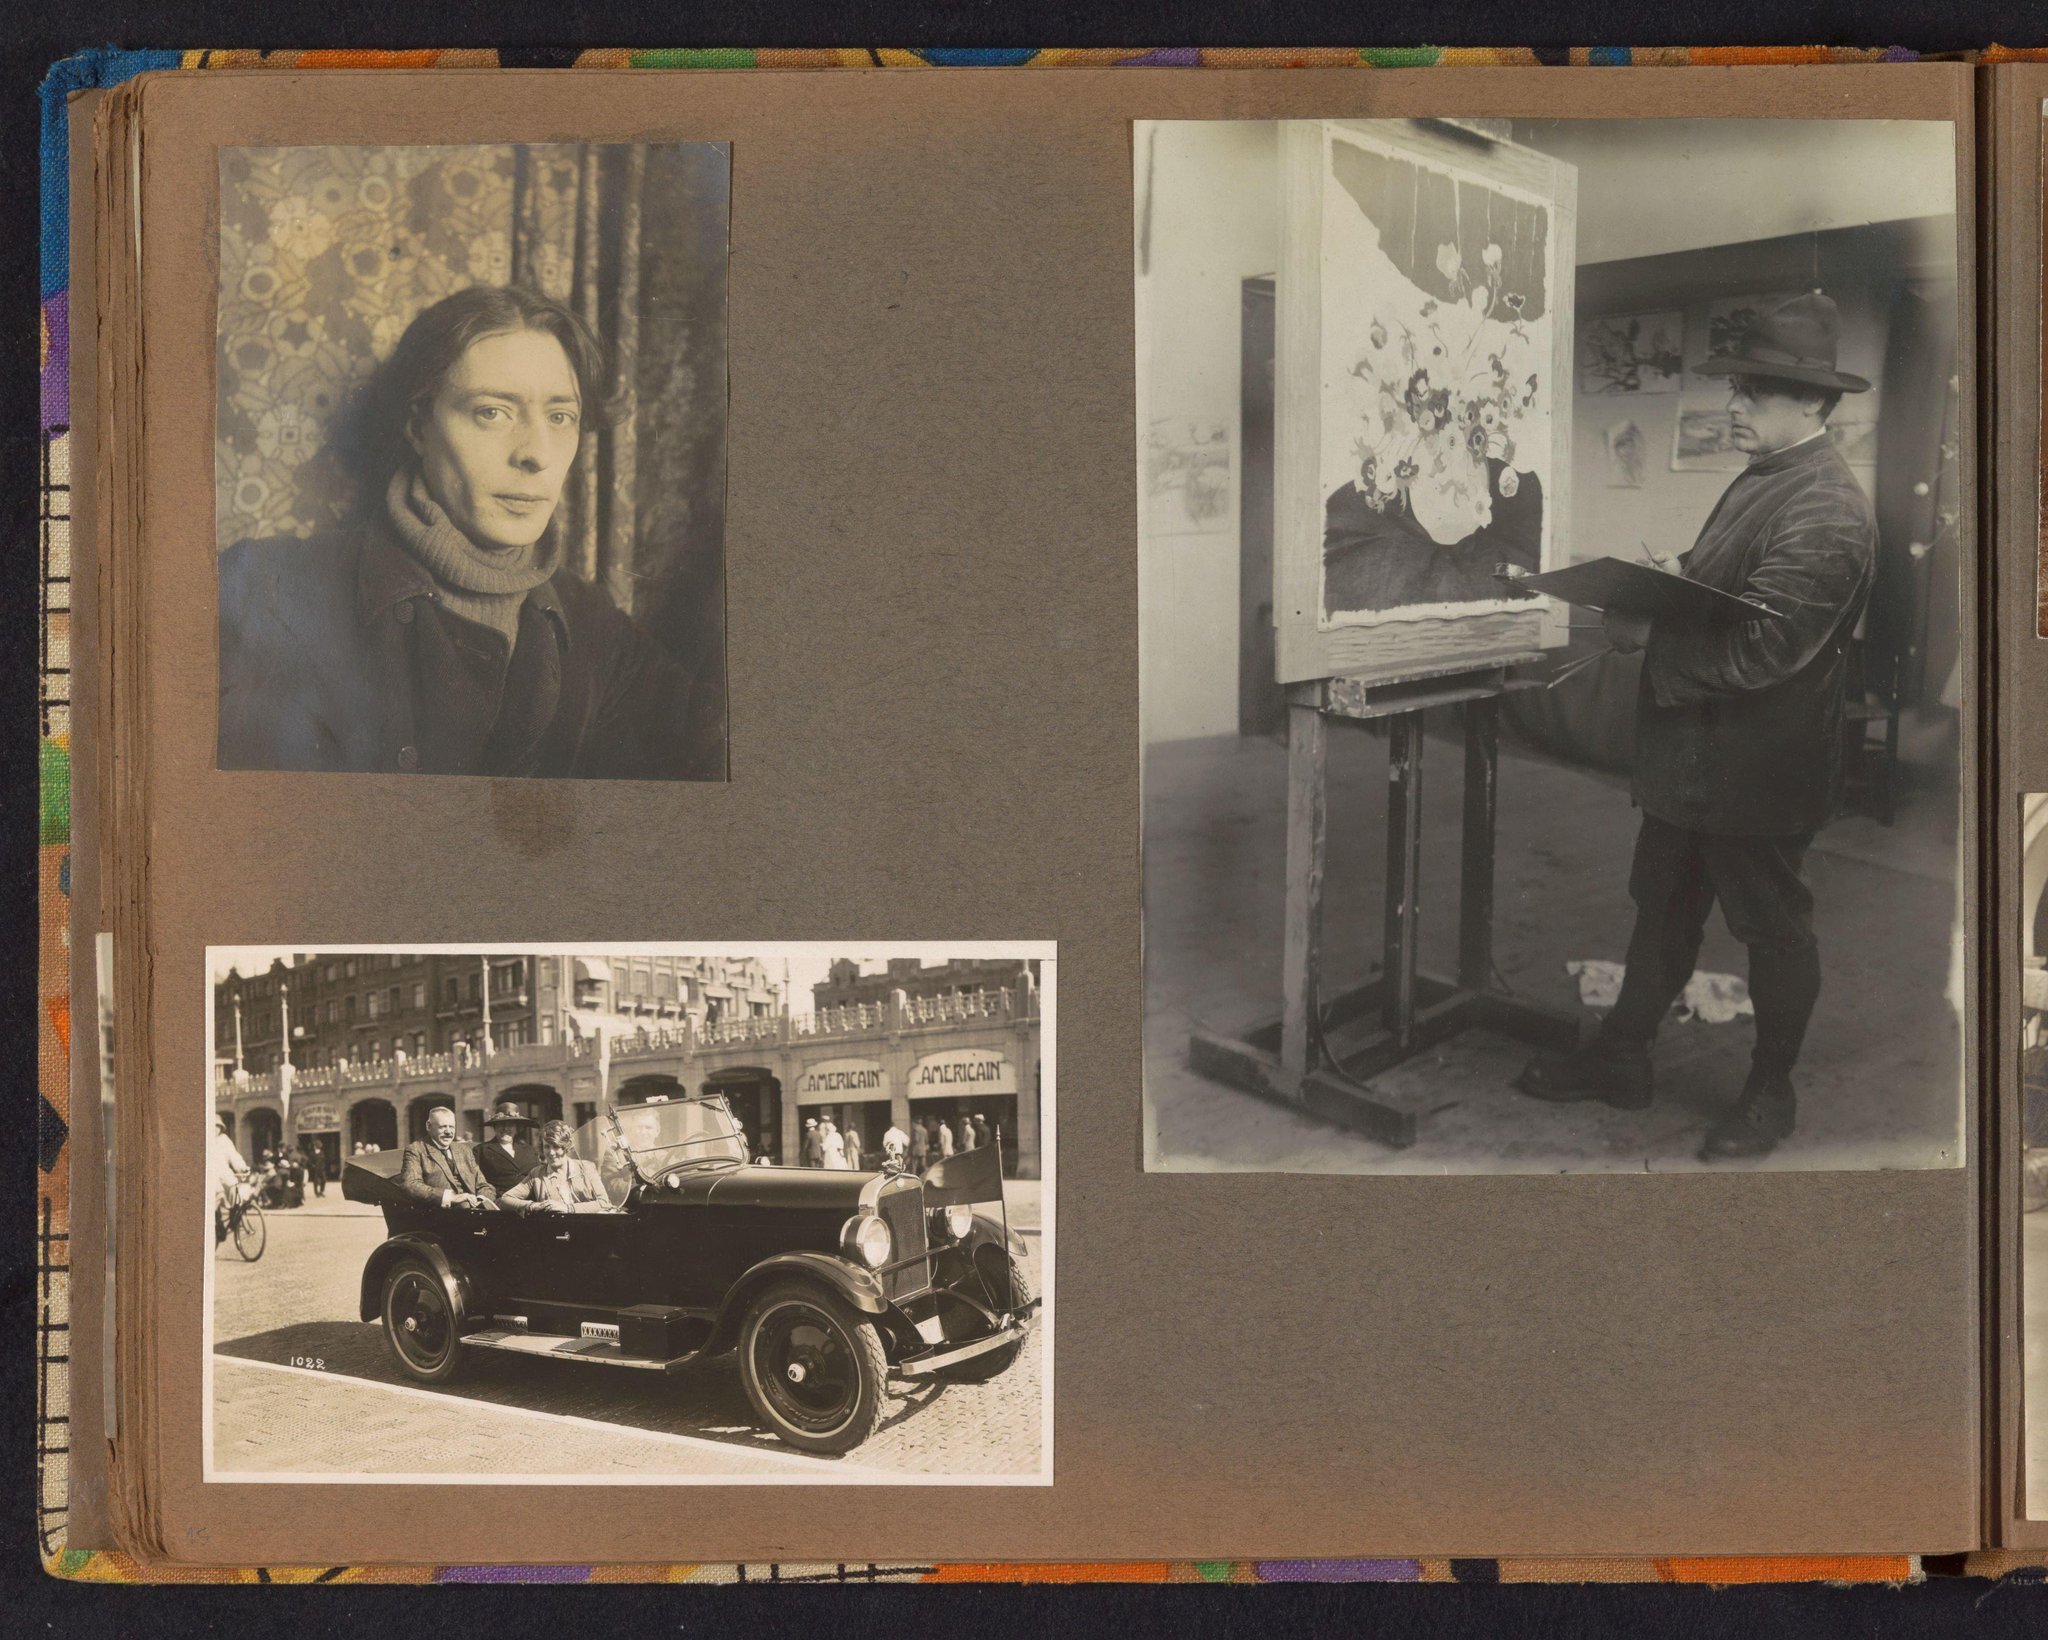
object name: photograph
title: Diverse afbeeldingen, onder meer van een schilder achter zijn ezel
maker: Anonymous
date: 1900-1925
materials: cardboard, photographic support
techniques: gelatin silver print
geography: netherlands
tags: adult man, painter at work, in his studio, automobile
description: Albumblad met foto's van een man met halflang haar, van een onbekende schilder staand achter zijn ezel en van twee stellen in een auto in Scheveningen. Onderdeel van Fotoalbum van een onbekende Nederlandse familie met connecties in Suriname en Nederlands-Indië (1).